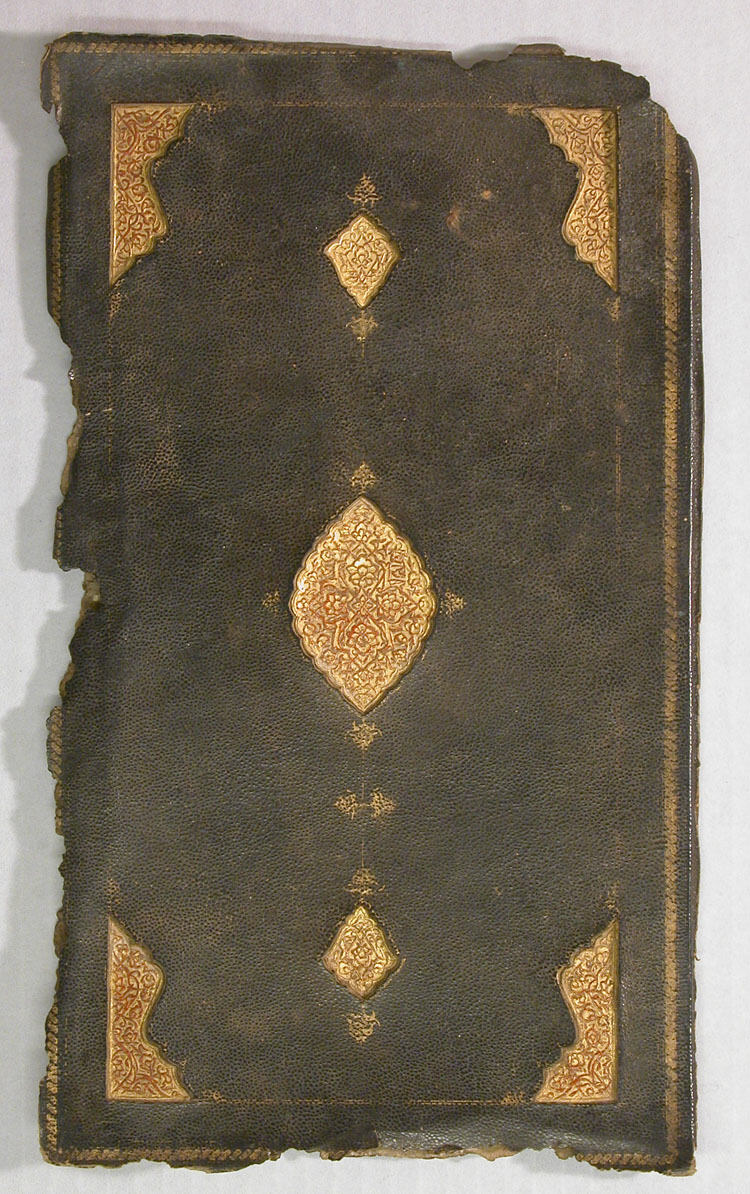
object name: fragment of a bookbinding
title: Fragment of a Bookbinding (Jild-i kitab)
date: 1601-1700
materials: leather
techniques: gilding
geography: iran